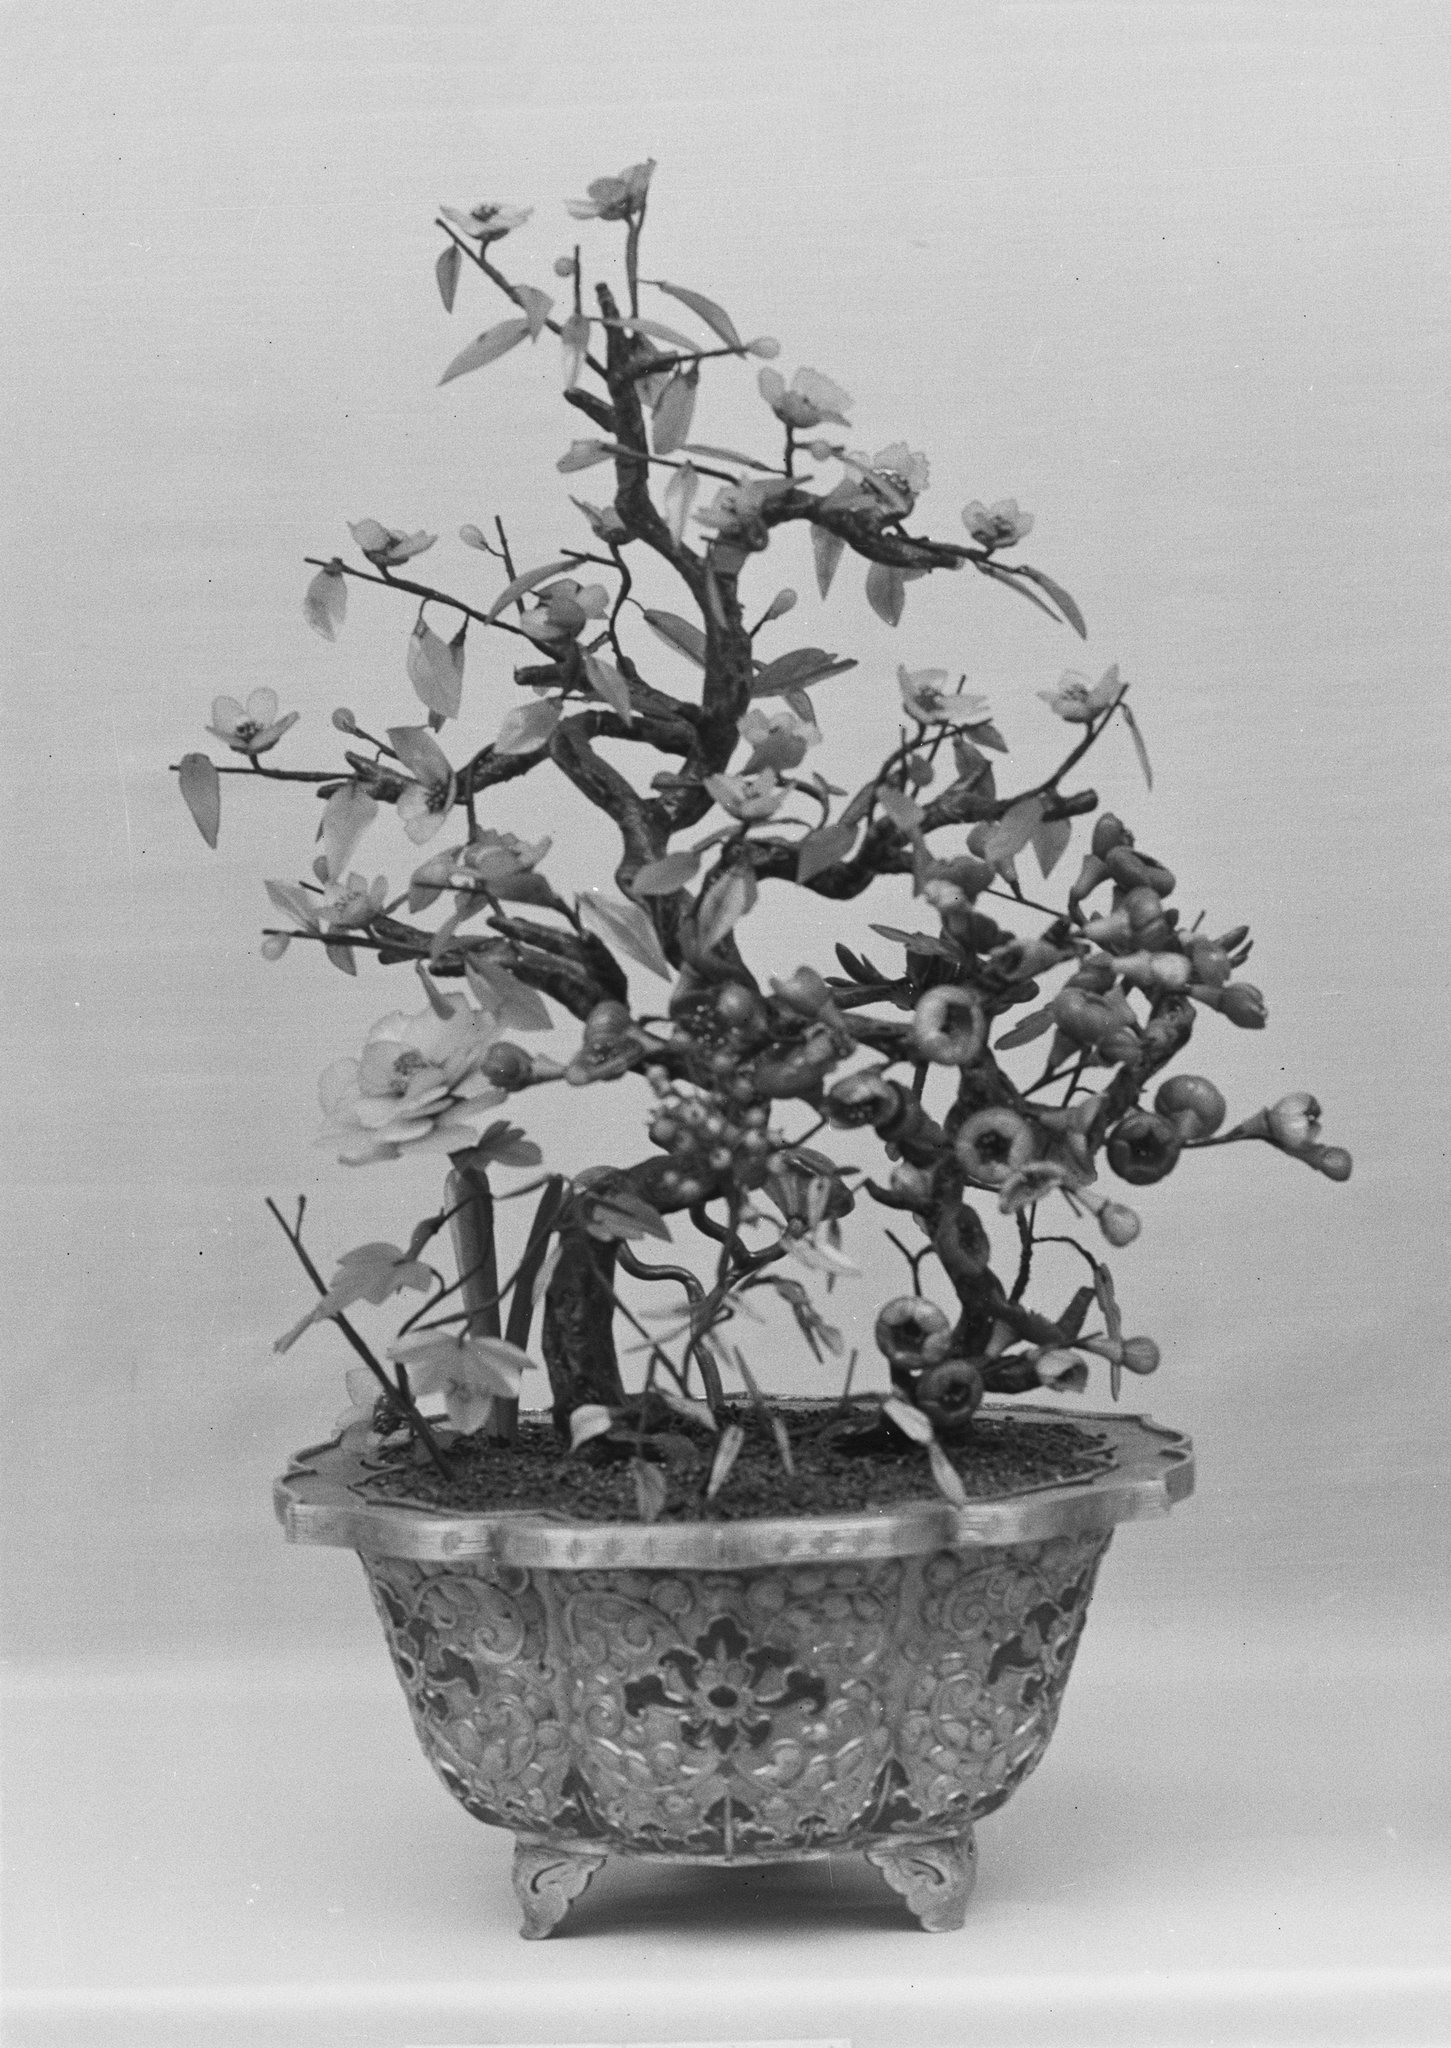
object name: pot with flowering plant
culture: chinese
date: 1796-1820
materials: jade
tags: flowers